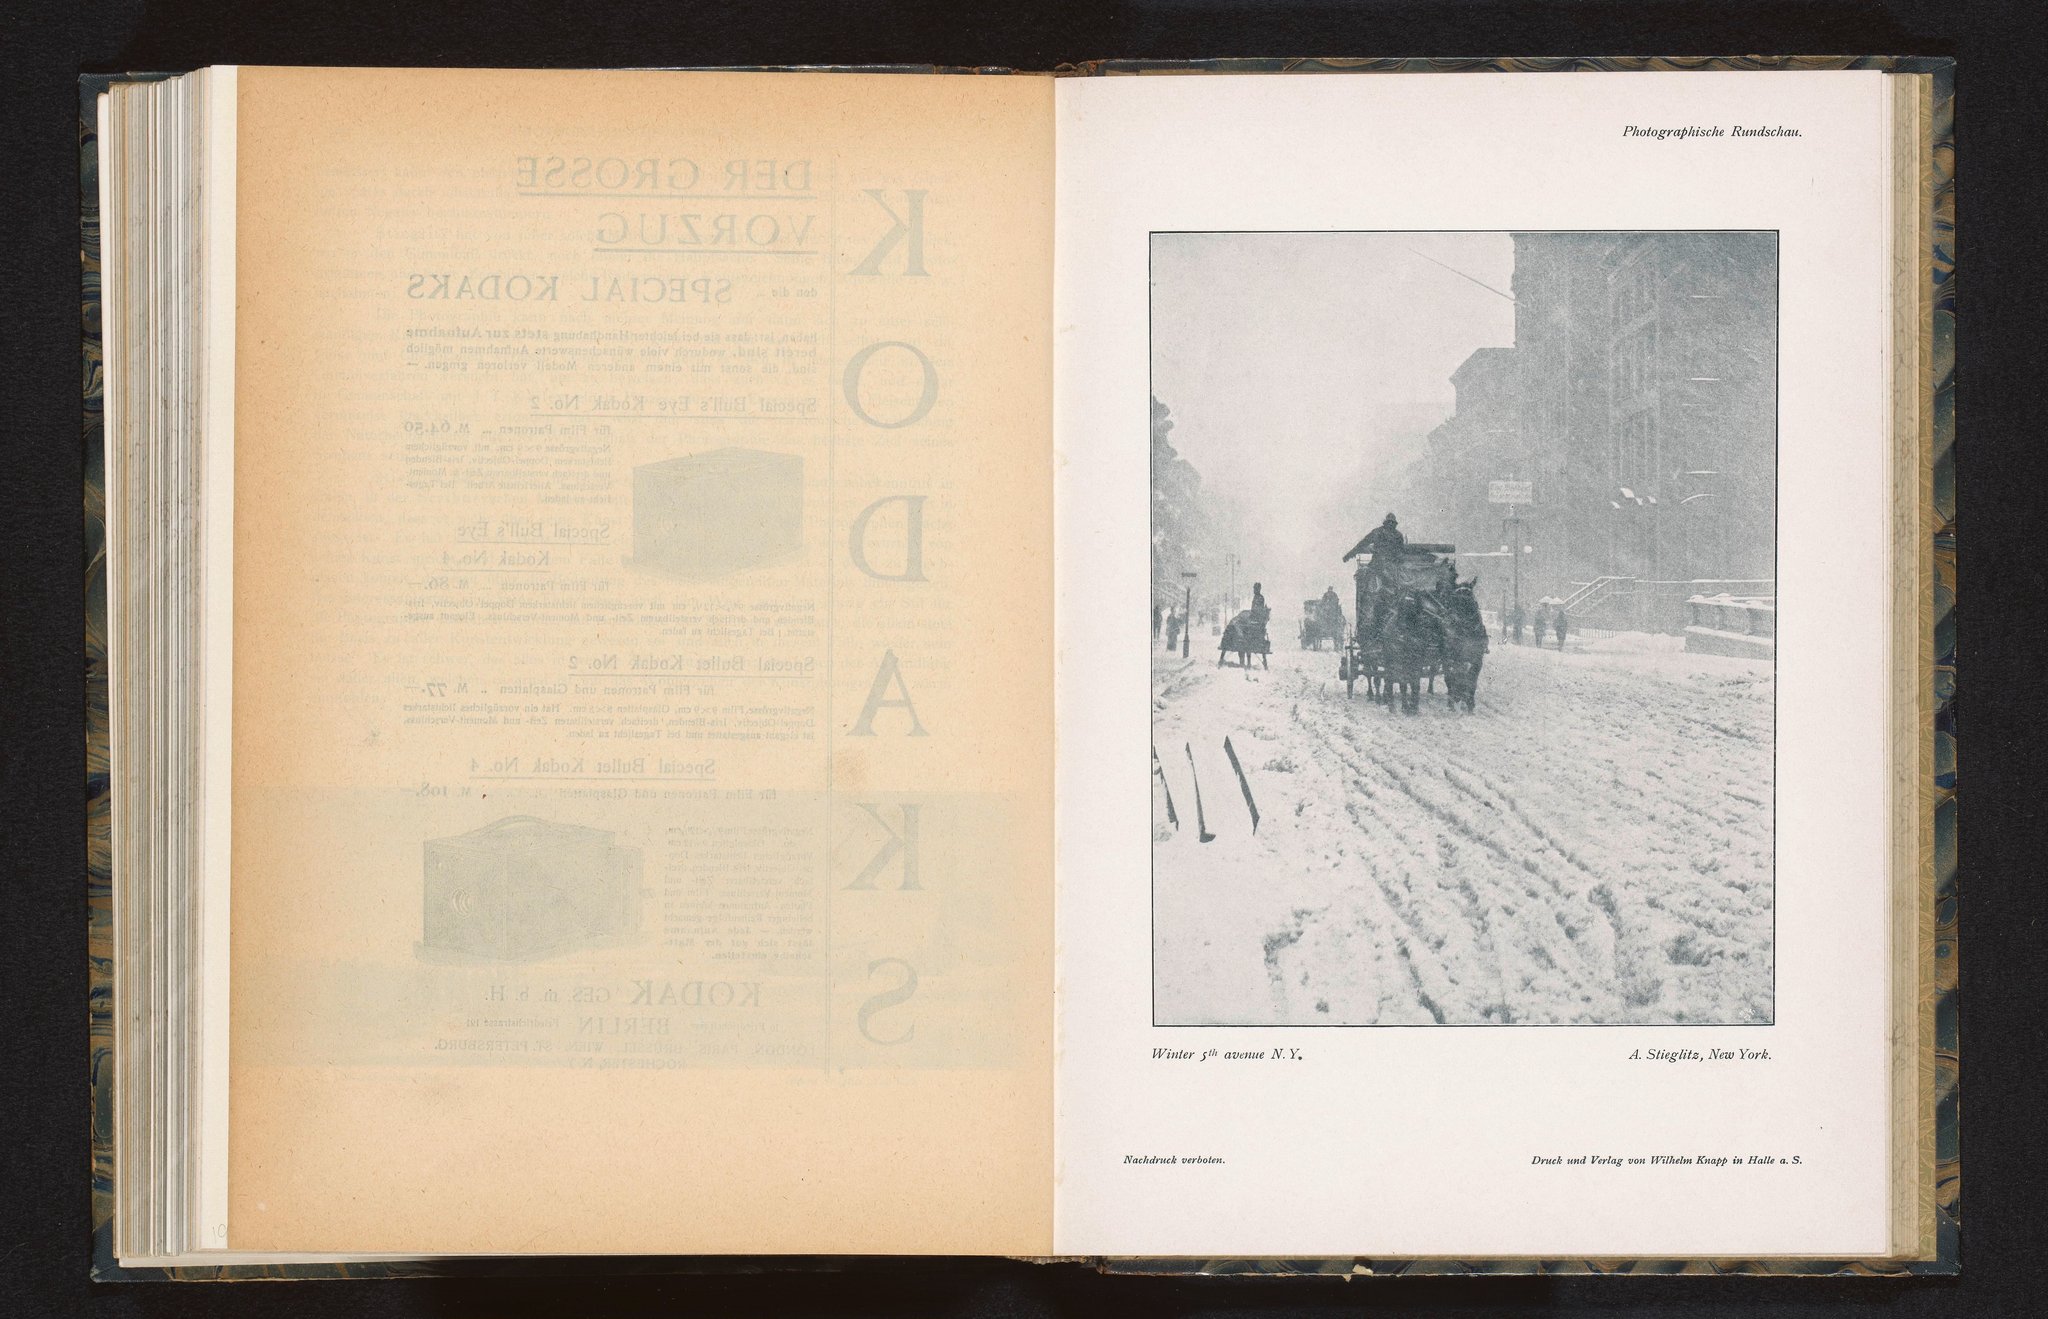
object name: photomechanical print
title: Winter 5th avenue N.Y.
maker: alfred stieglitz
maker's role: fotograaf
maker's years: 1864-1946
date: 1895-1900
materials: paper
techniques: autotype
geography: new york city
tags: four-wheeled, animal-drawn vehicle, e.g.: cab, carriage, coach, snow, street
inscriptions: monogram: ‘MR&C’